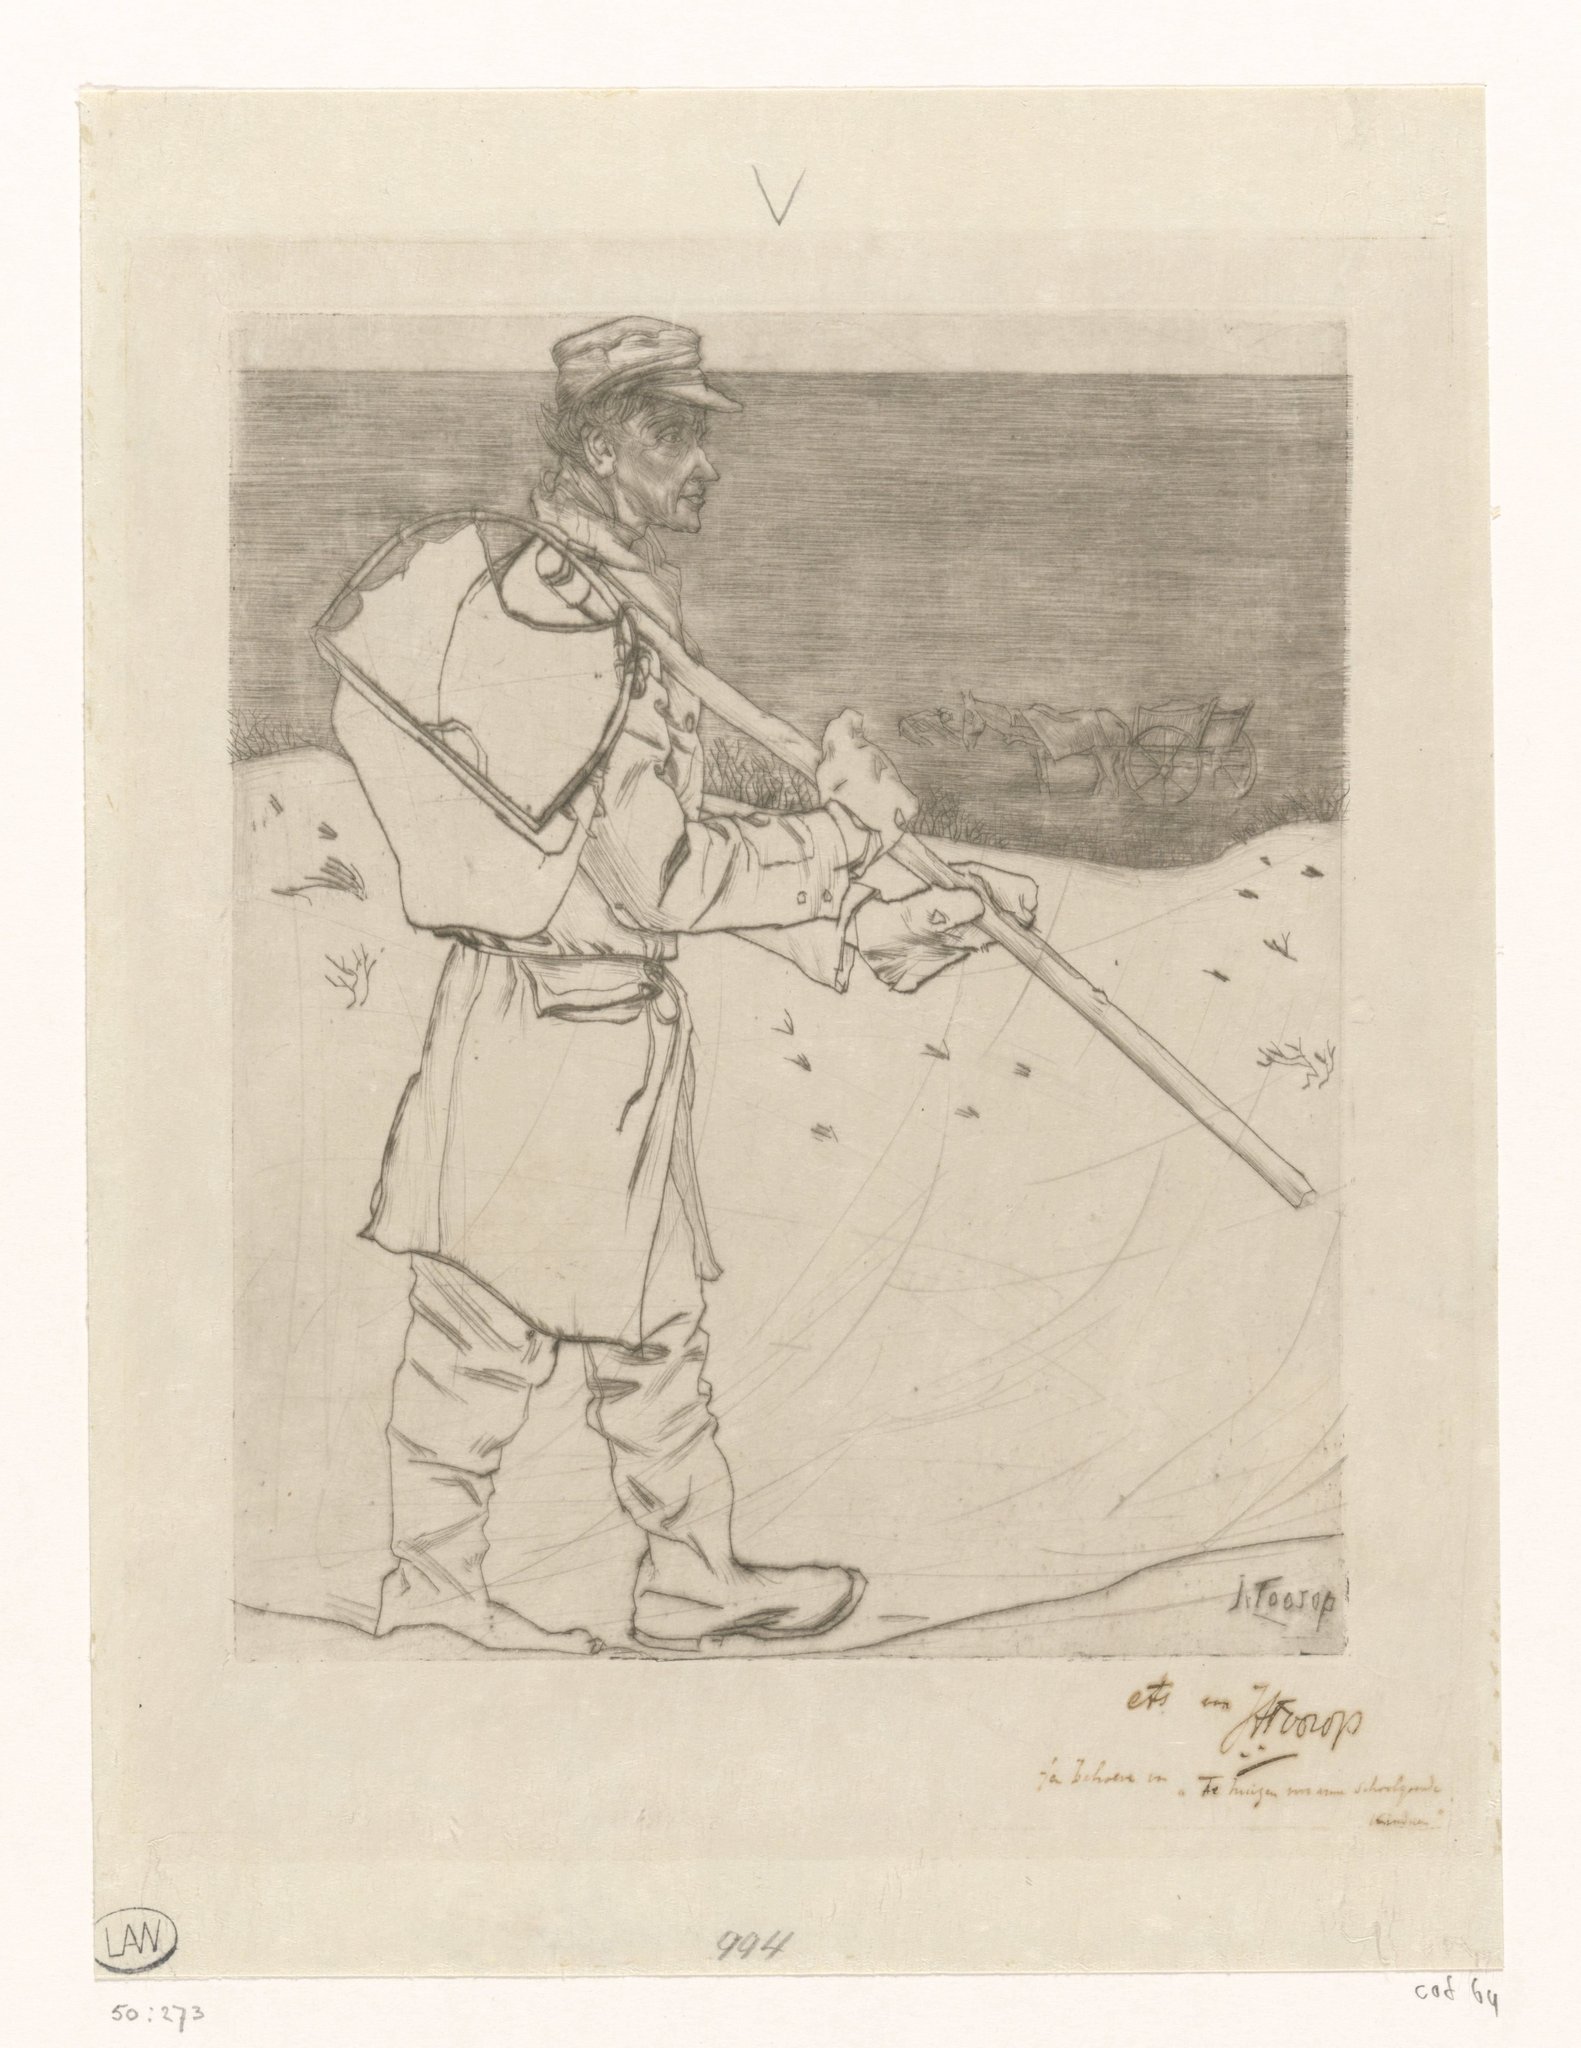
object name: print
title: De schelpenvisser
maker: jan toorop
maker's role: draughtsman, painter, print maker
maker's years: 1858-1928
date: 1902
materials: paper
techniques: drypoint, intaglio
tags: shell fishery, beach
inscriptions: annotation: ‘Ets van J. Th. Toorop/ ten behoeve van "Te huizen voor arme schoolgaande kinderen"’, collector's mark: Lugt 1713a, collector's mark: Lugt 2228